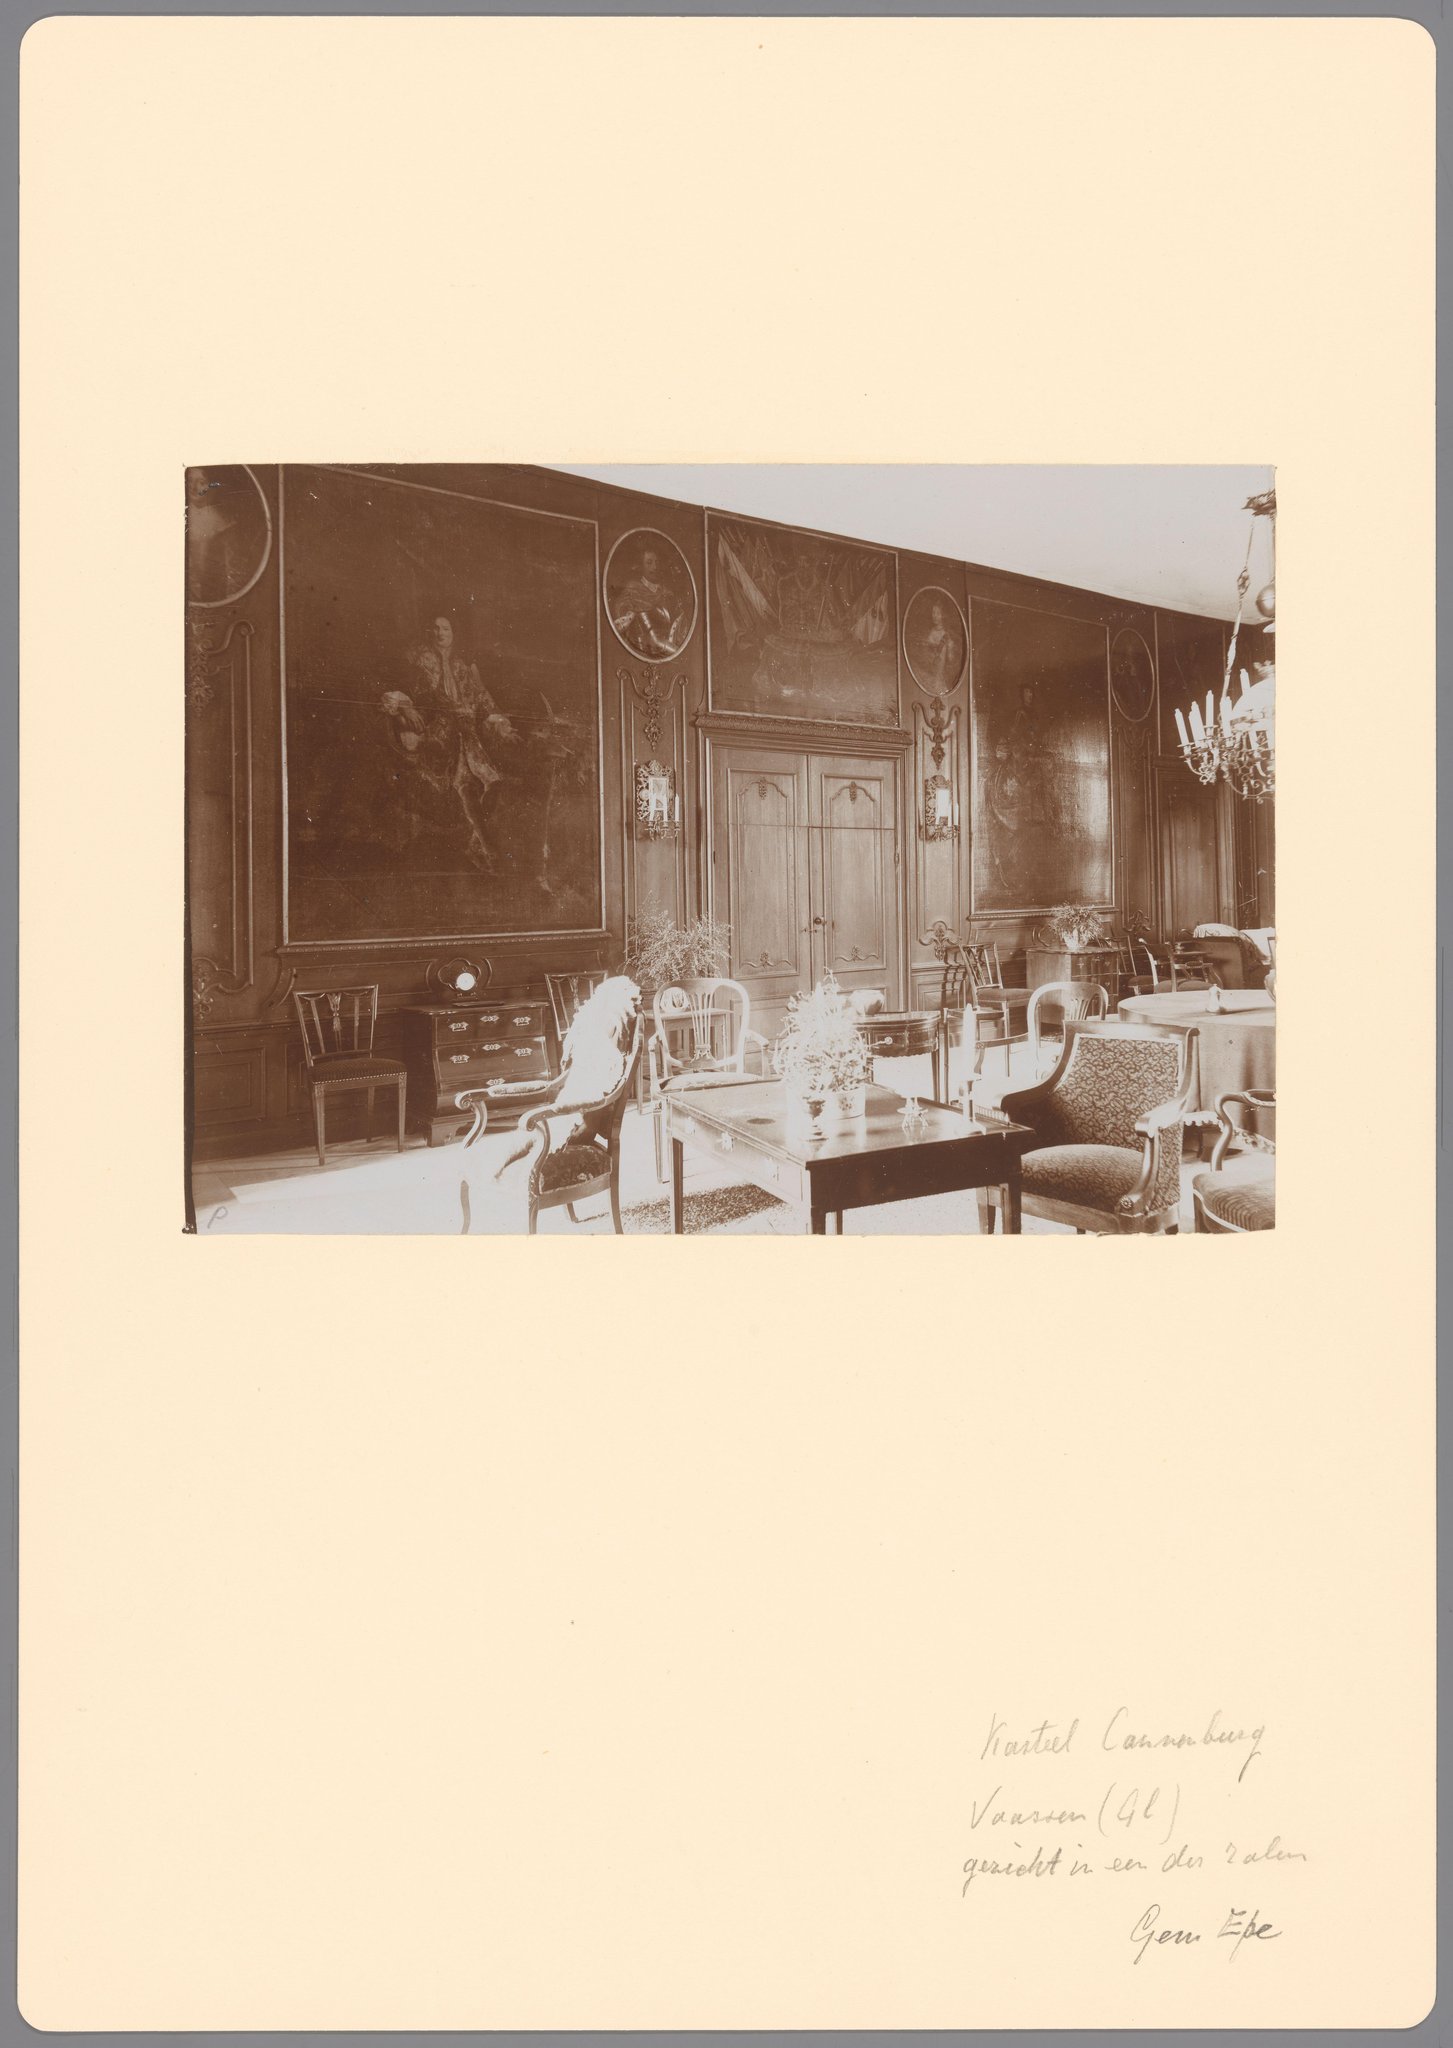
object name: photograph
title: Interieur van een zaal in Kasteel Cannenburgh te Vaassen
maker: anoniem (monumentenzorg)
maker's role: fotograaf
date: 1890-1920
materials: cardboard, photographic support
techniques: collodion silver print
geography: kasteel cannenburgh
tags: castle, living-room, parlour, sitting-room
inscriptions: annotation: ‘Q/ Kasteel Cannenburg/ Vaassen (Gl.)/ gezicht in een der zalen/ gem. Epe’